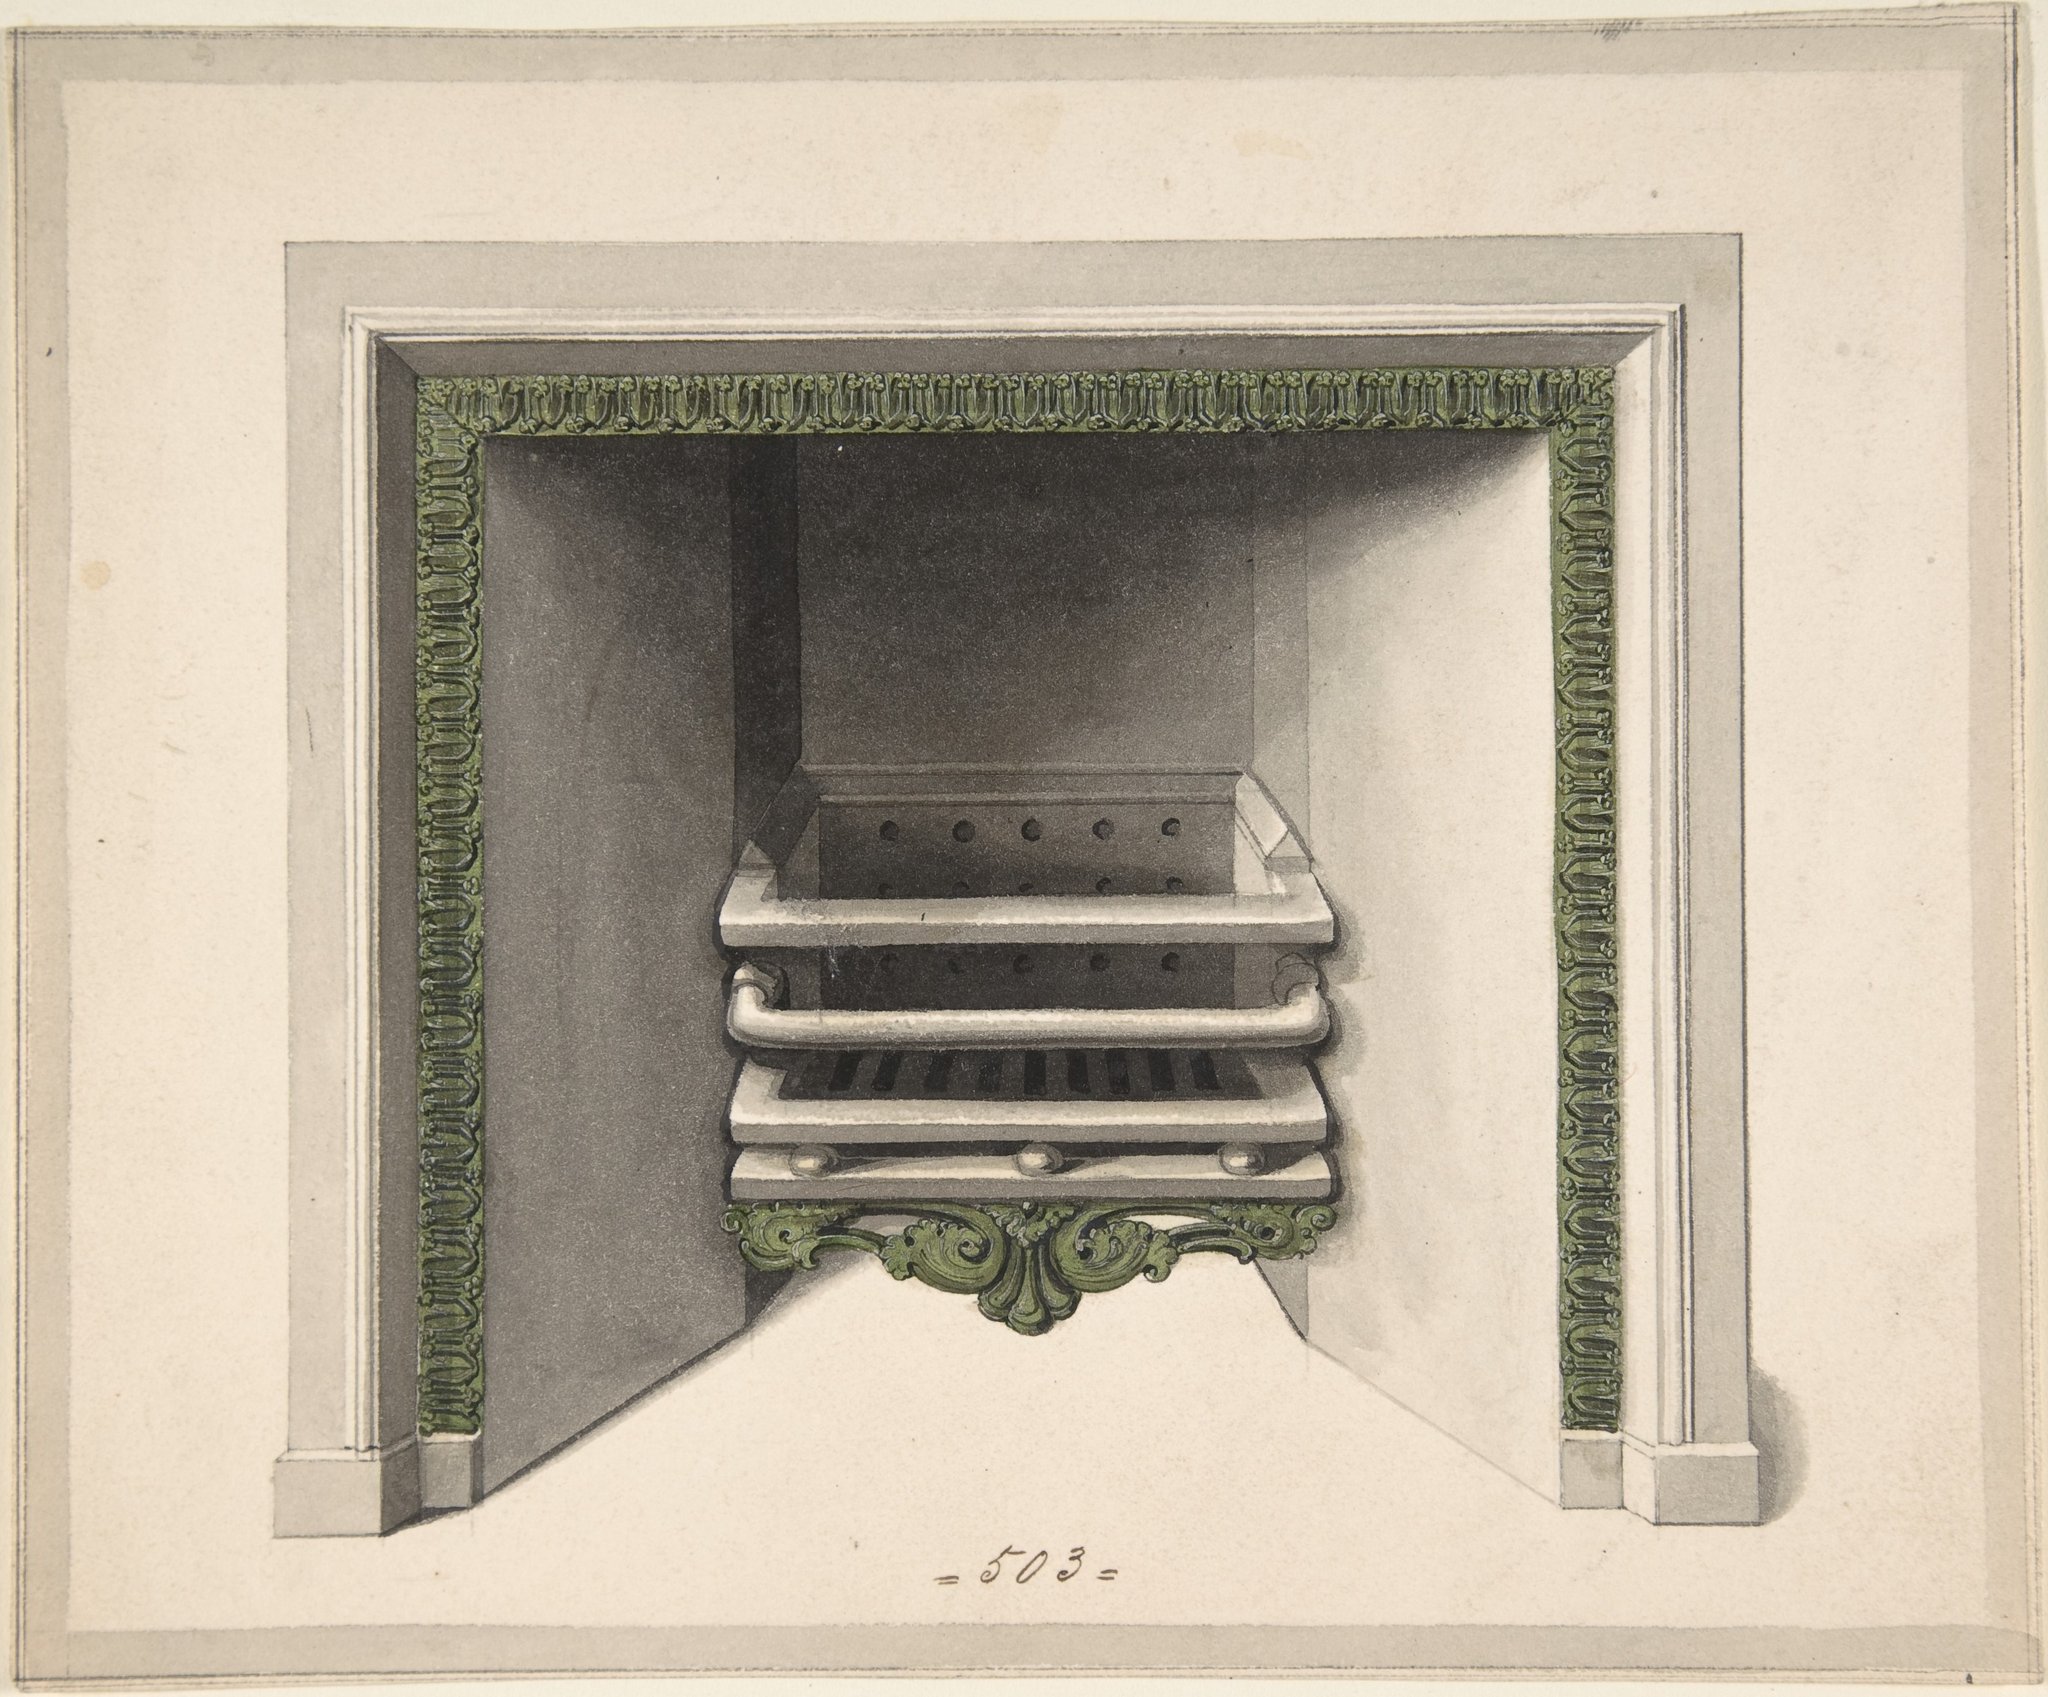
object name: drawing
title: Design for Cast-iron Grate with Eagles Grasping Snakes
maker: benjamin dean wyatt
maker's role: artist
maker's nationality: british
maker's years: 1775-1850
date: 1814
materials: ink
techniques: brush, pen, wash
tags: ornament